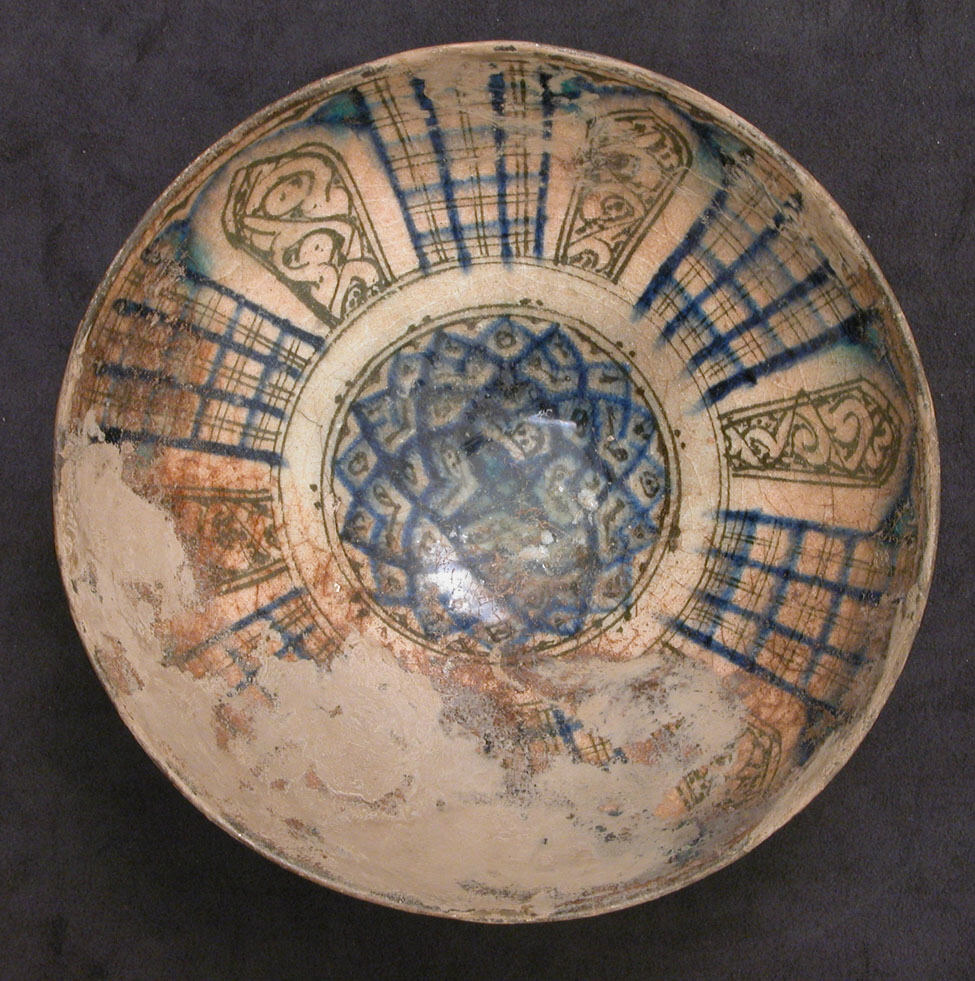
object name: bowl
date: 1301-1400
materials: glaze, stonepaste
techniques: painting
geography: syria